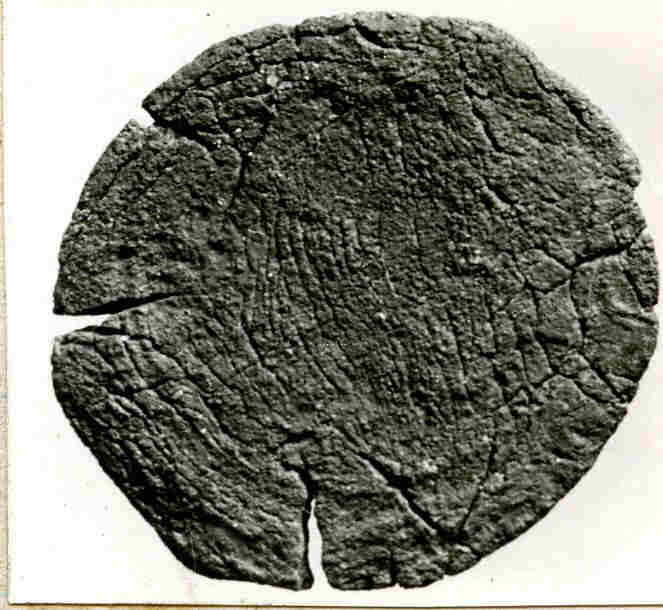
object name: coin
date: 797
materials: copper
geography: iran